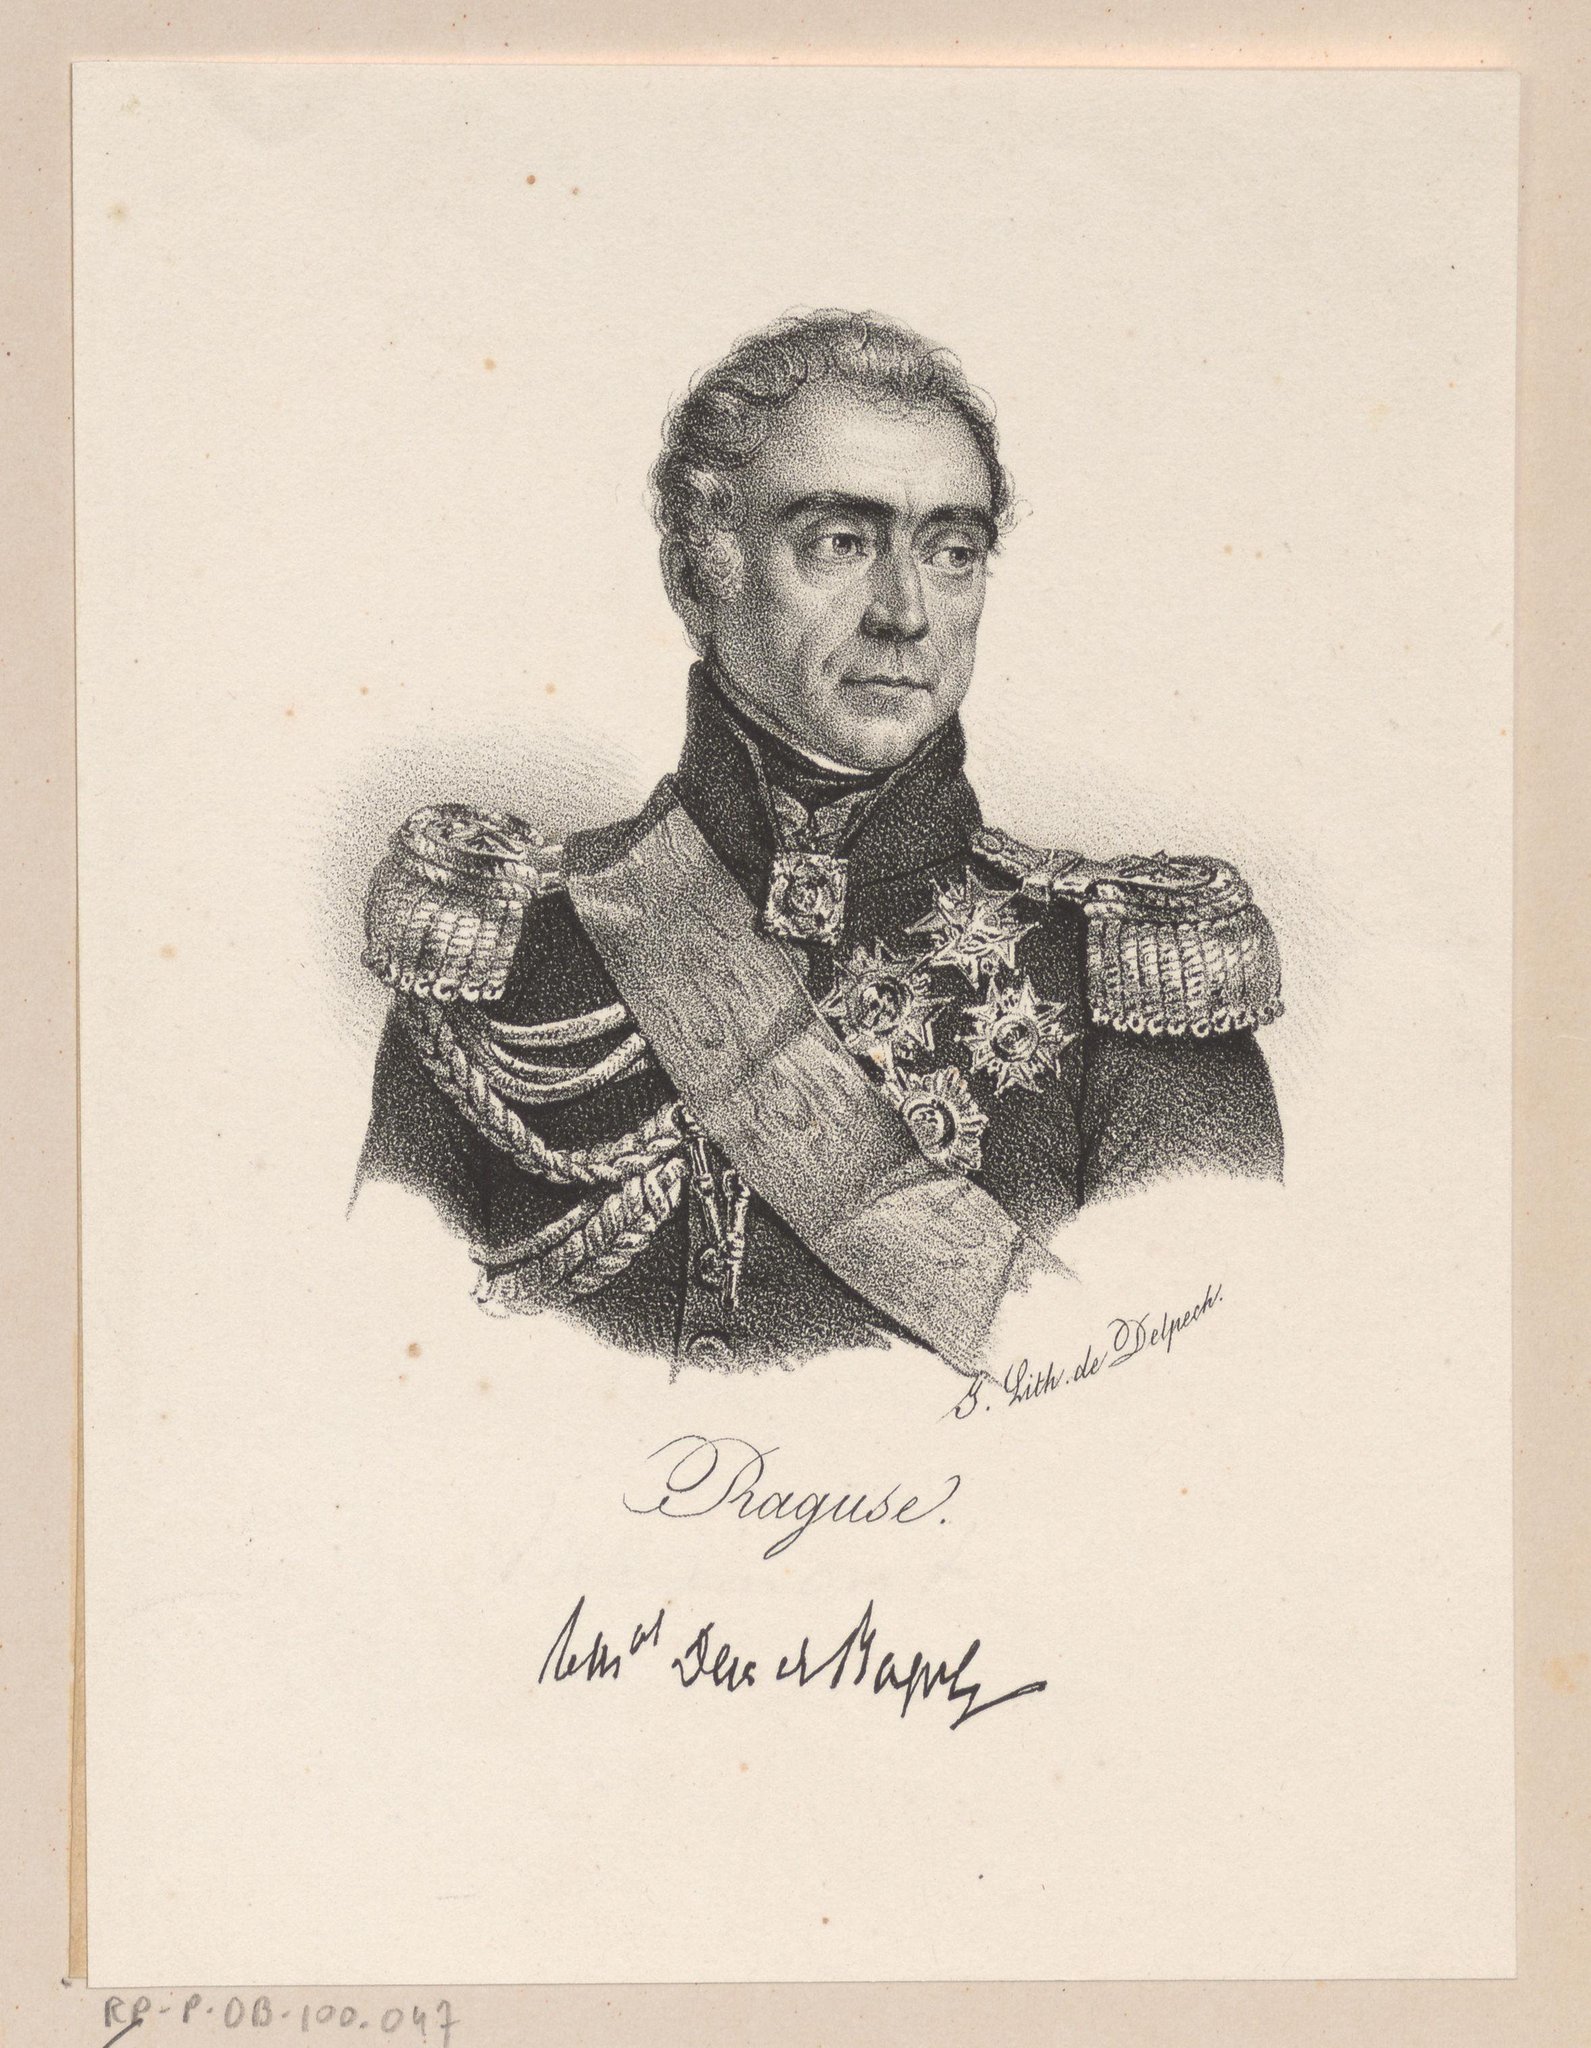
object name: print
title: Raguse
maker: Anonymous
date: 1818-1842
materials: paper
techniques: lithograph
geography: france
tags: venice, historical persons, (military) uniforms